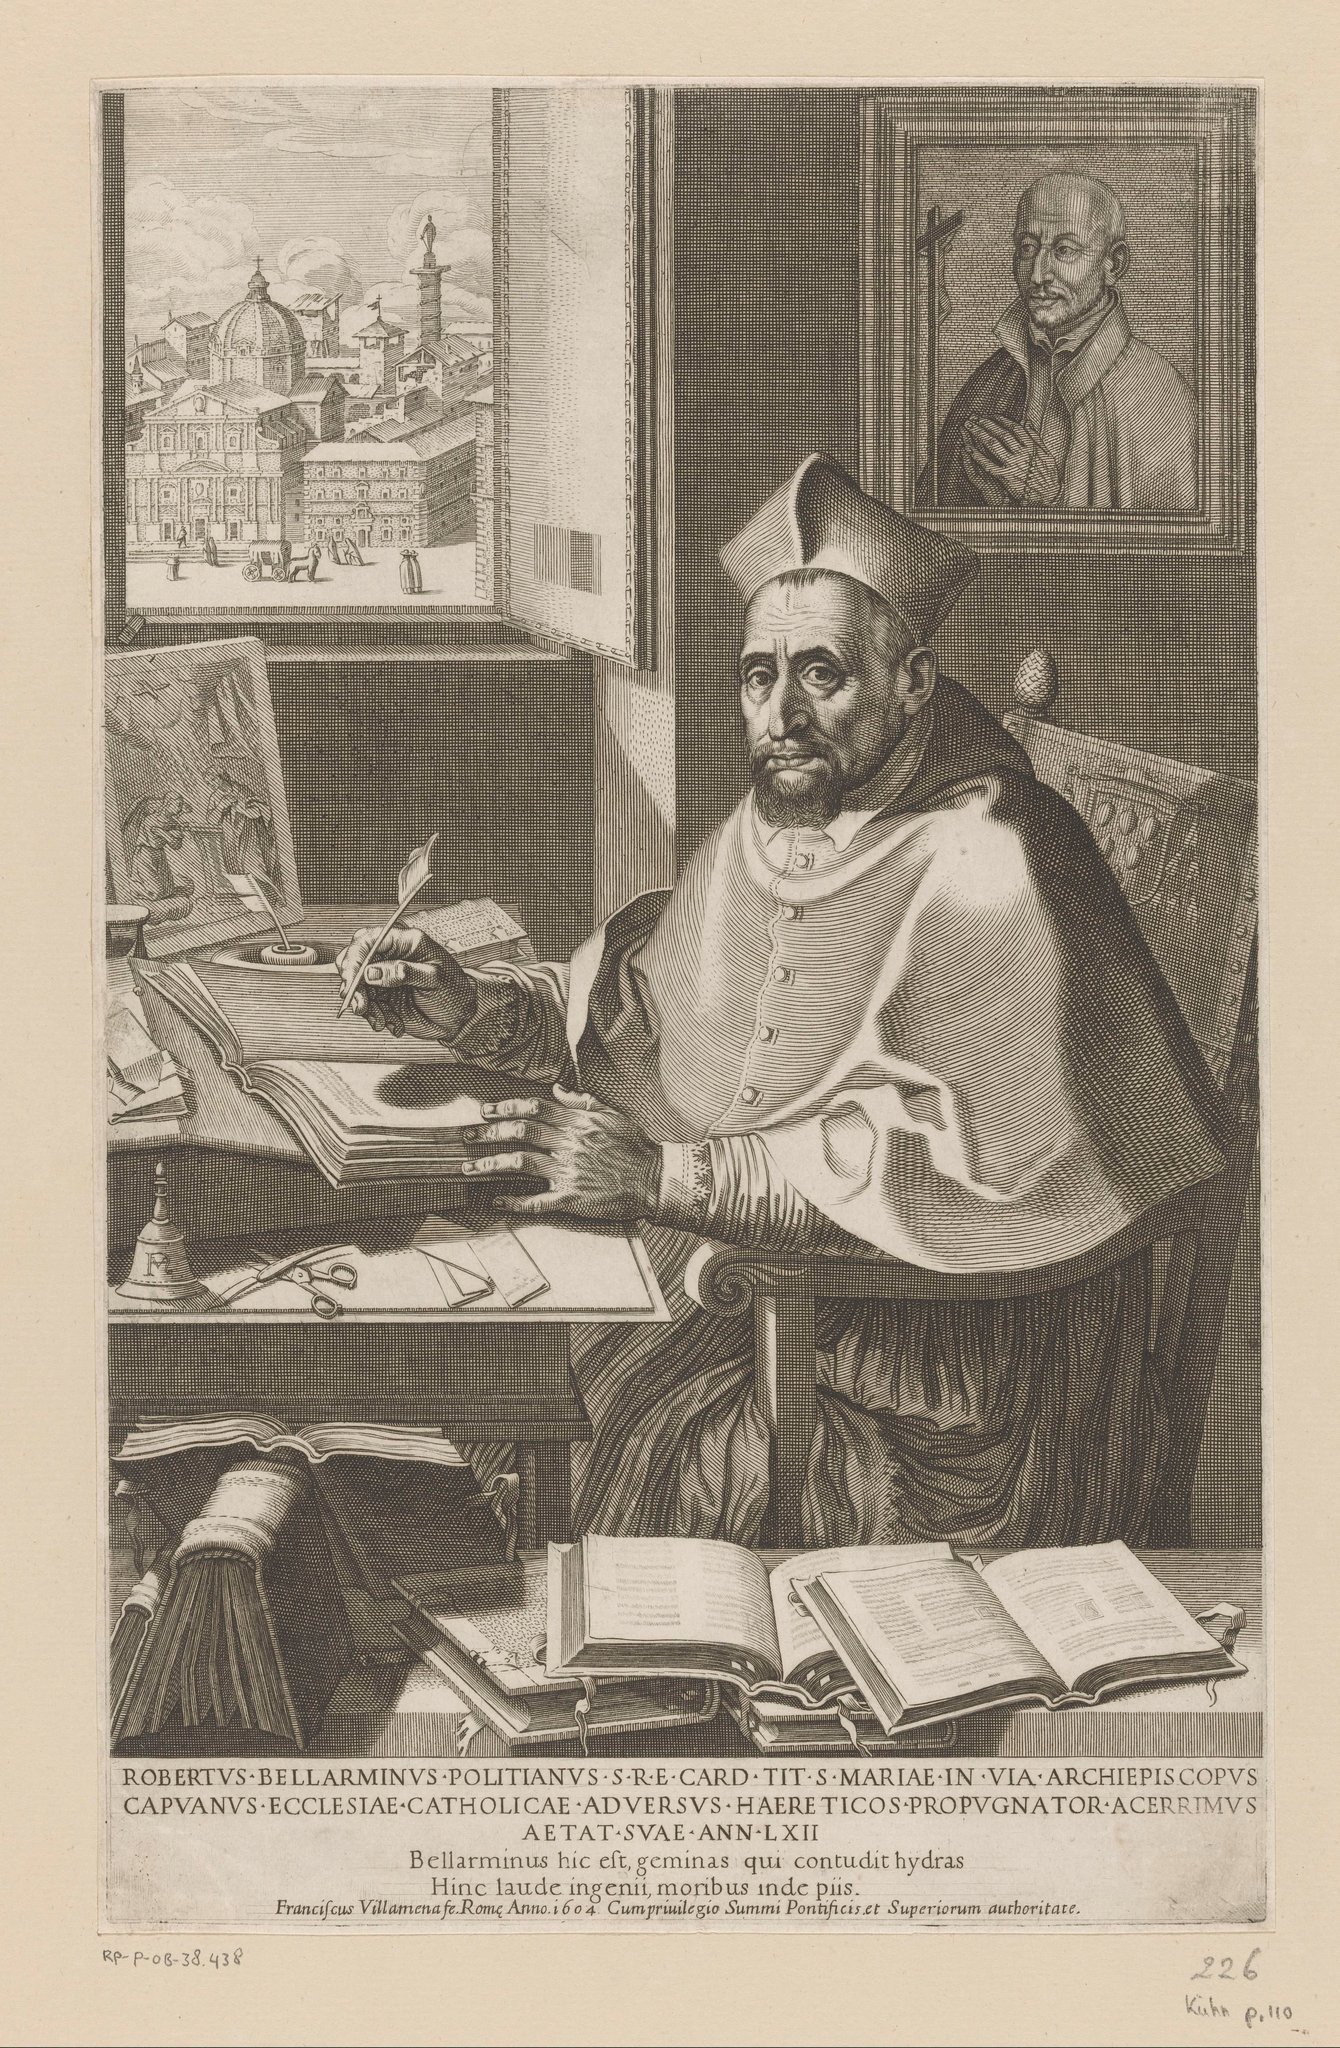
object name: print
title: Portret van kardinaal Roberto Bellarmino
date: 1604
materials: paper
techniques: engraving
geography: rome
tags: cardinal, historical persons, study; 'studiolo'; library, the founder of the jesuit order, ignatius of loyola; possible attributes: book (with 'ad majorem dei gloriam'), demon, dragon under feet, flames, flaming heart, globe, ihs monogram, skull (with crown), tears in eyes, torch, the annunciation: mary, usually reading, is visited by the angel (sometimes a woman overhears the conversation)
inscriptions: collector's mark: Lugt 240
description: Kardinaal Roberto Bellarmino zittend achter een schrijftafel. Op de voorgrond liggen boeken en op tafel staat een afbeelding van de Annunciatie. Aan de muur hangt een portret van de heilige Ignatius van Loyola en het raam links biedt een doorkijk naar Il Gesù en de zuil van Trajanus te Rome. Vijf regels Latijnse tekst in ondermarge.